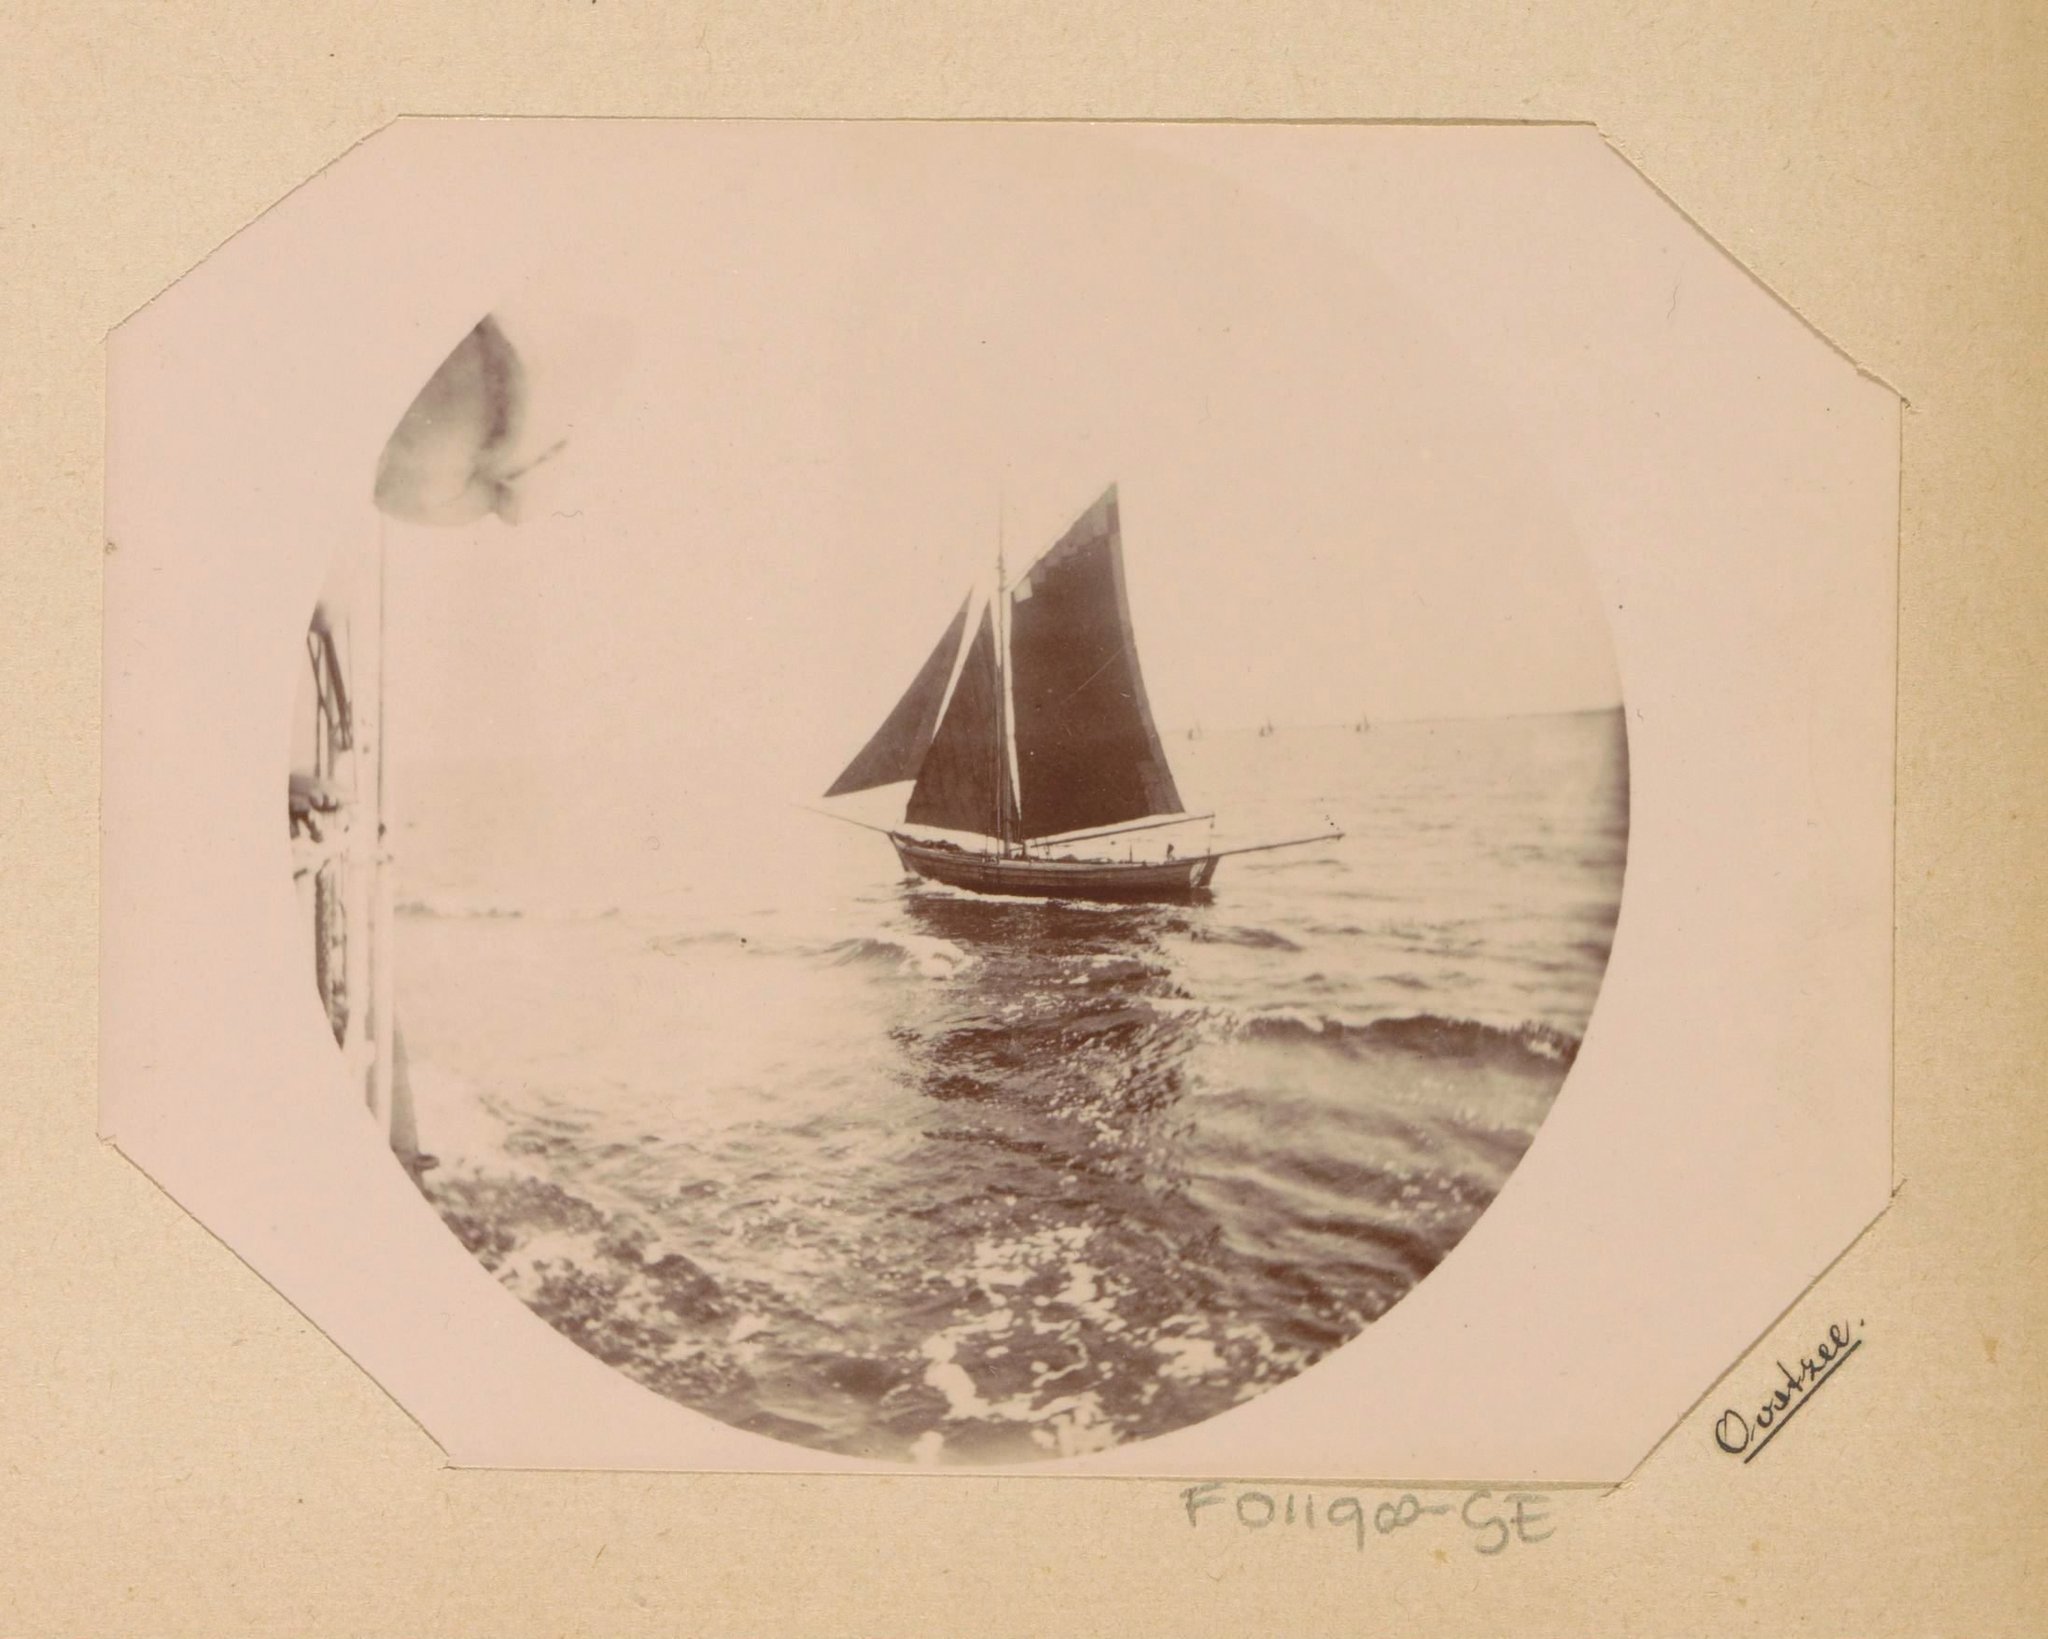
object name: album leaf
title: Oostzee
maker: willem frederik piek jr.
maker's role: fotograaf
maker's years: 1874-1954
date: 1889-1893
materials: paper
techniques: gelatin silver print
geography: baltic sea region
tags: sailing-ship, sailing-boat